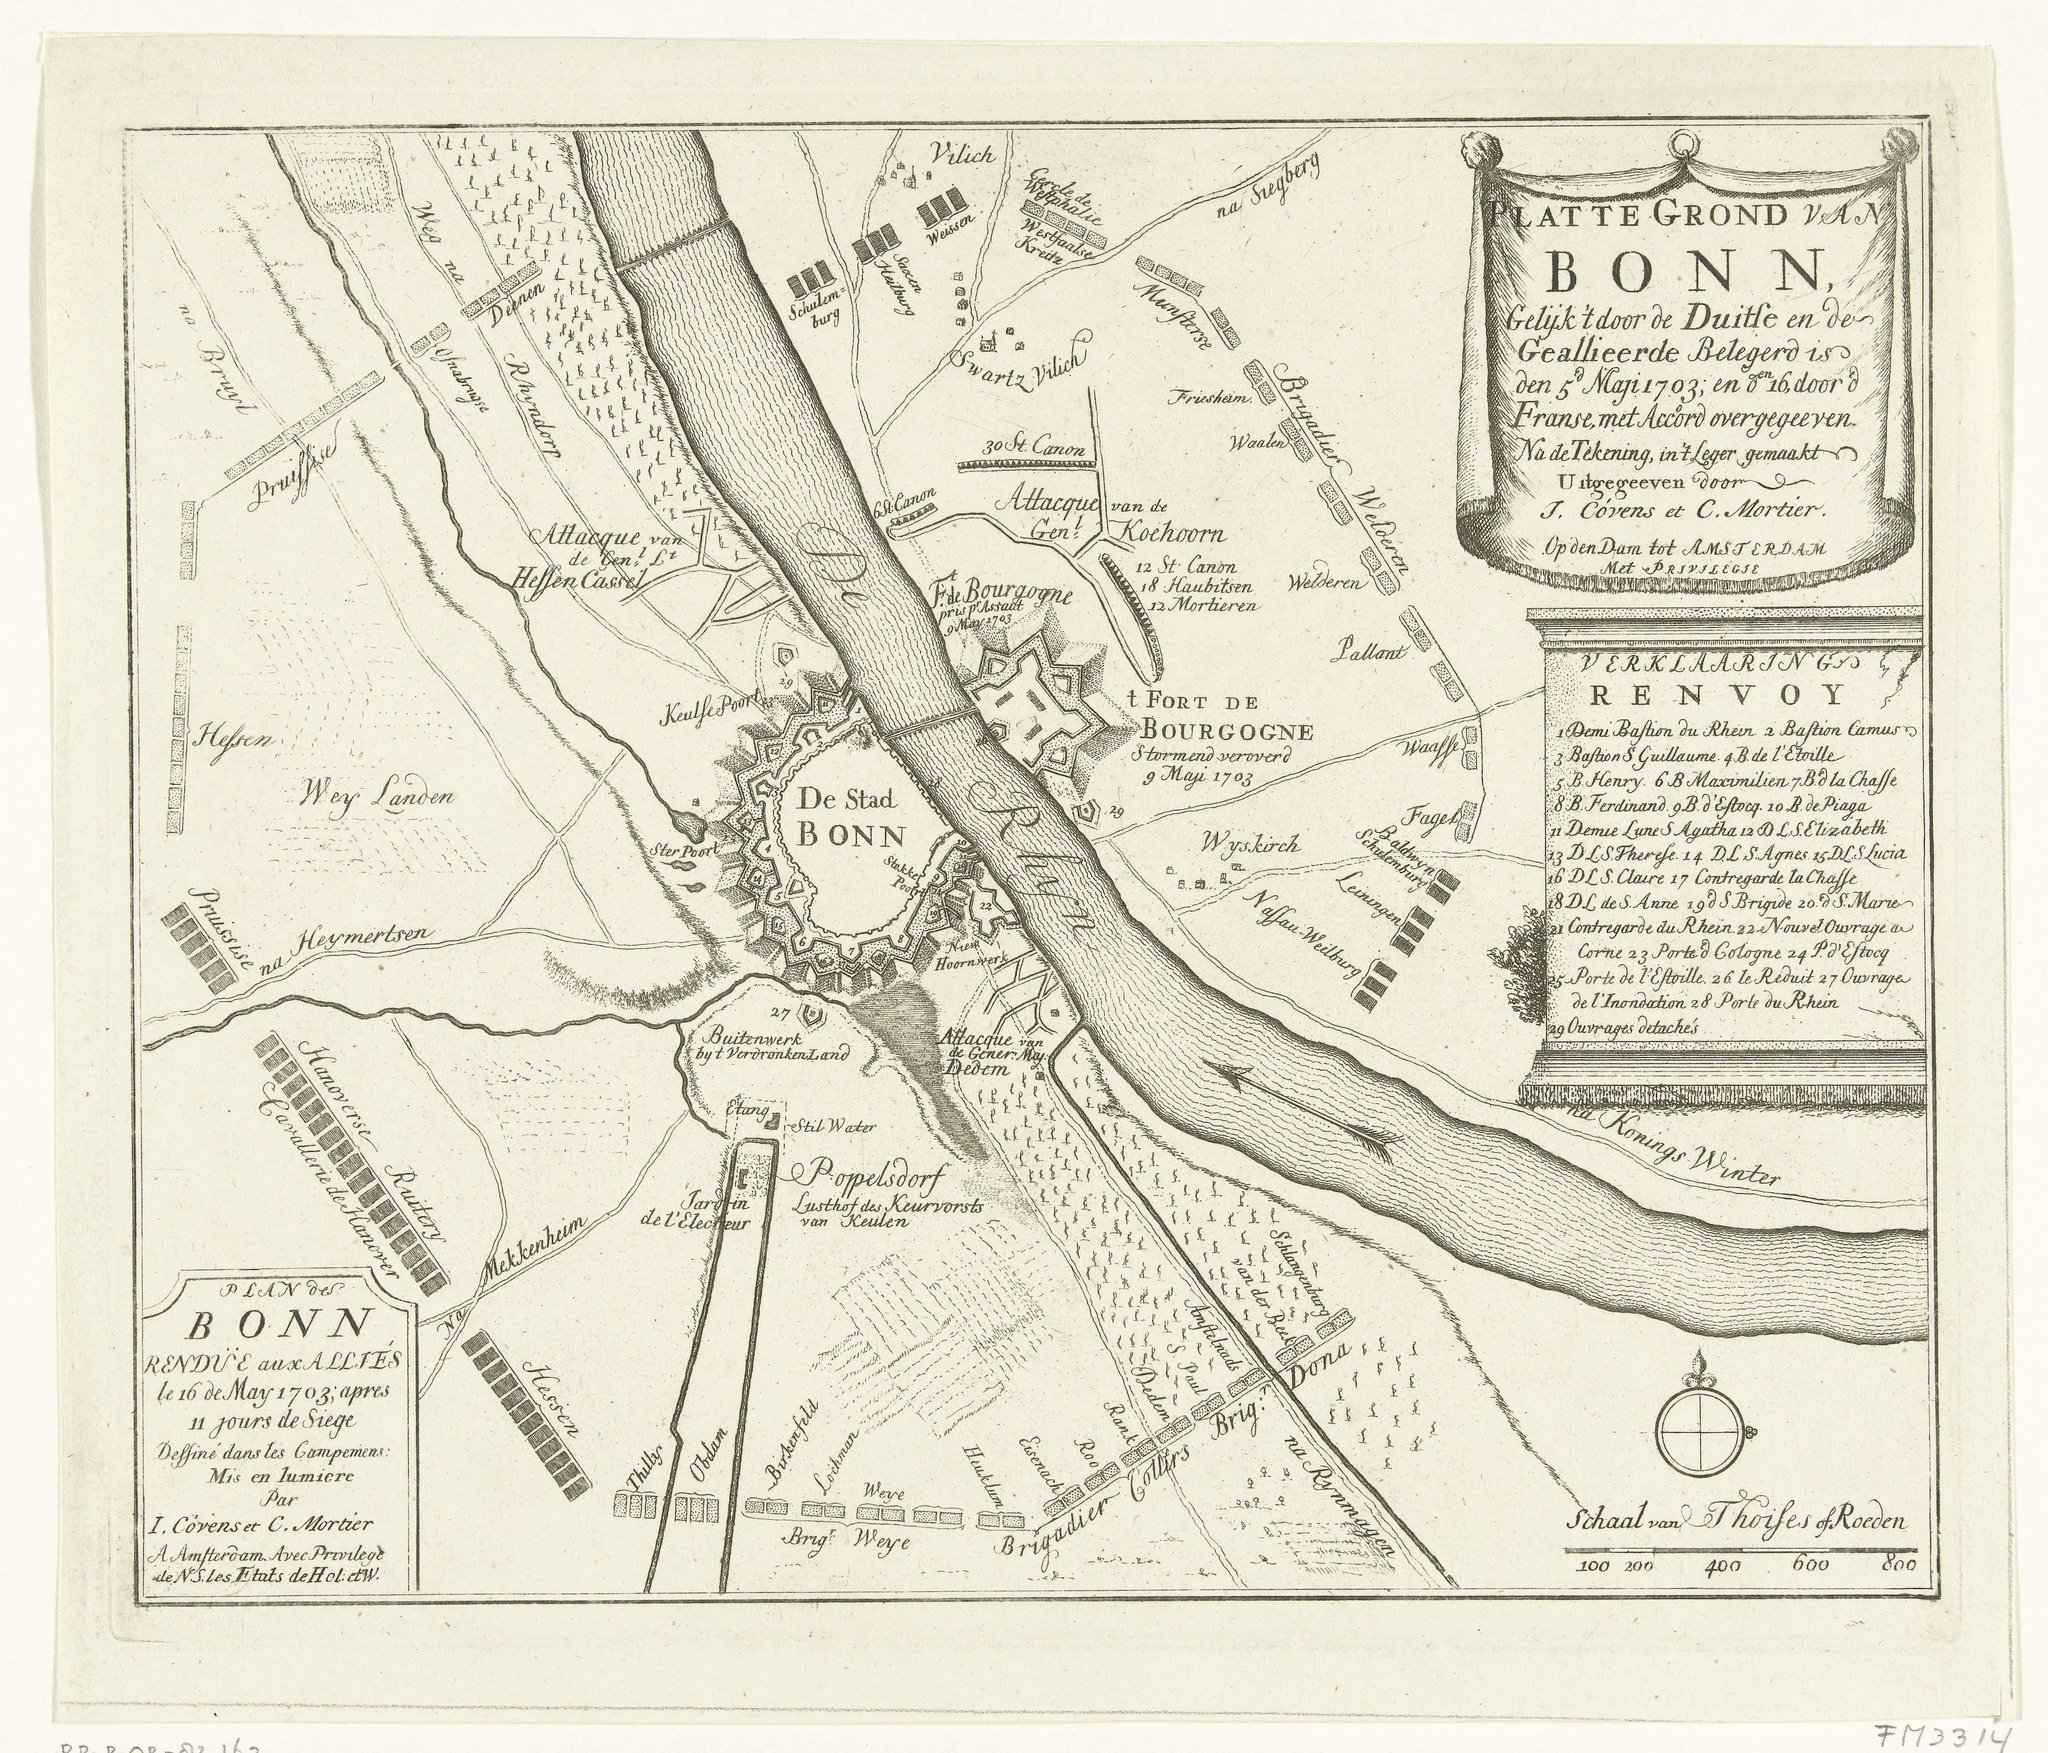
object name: map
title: Kaart van het beleg van Bonn door de Geallieerden, 1703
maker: Anonymous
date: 1703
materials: paper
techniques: etching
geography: amsterdam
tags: siege, position war, maps of cities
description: Kaart van Bonn en het omliggende land, belegerd door de Geallieerden vanaf 5 mei 1703 en dat op 16 mei door de Fransen is overgegeven.